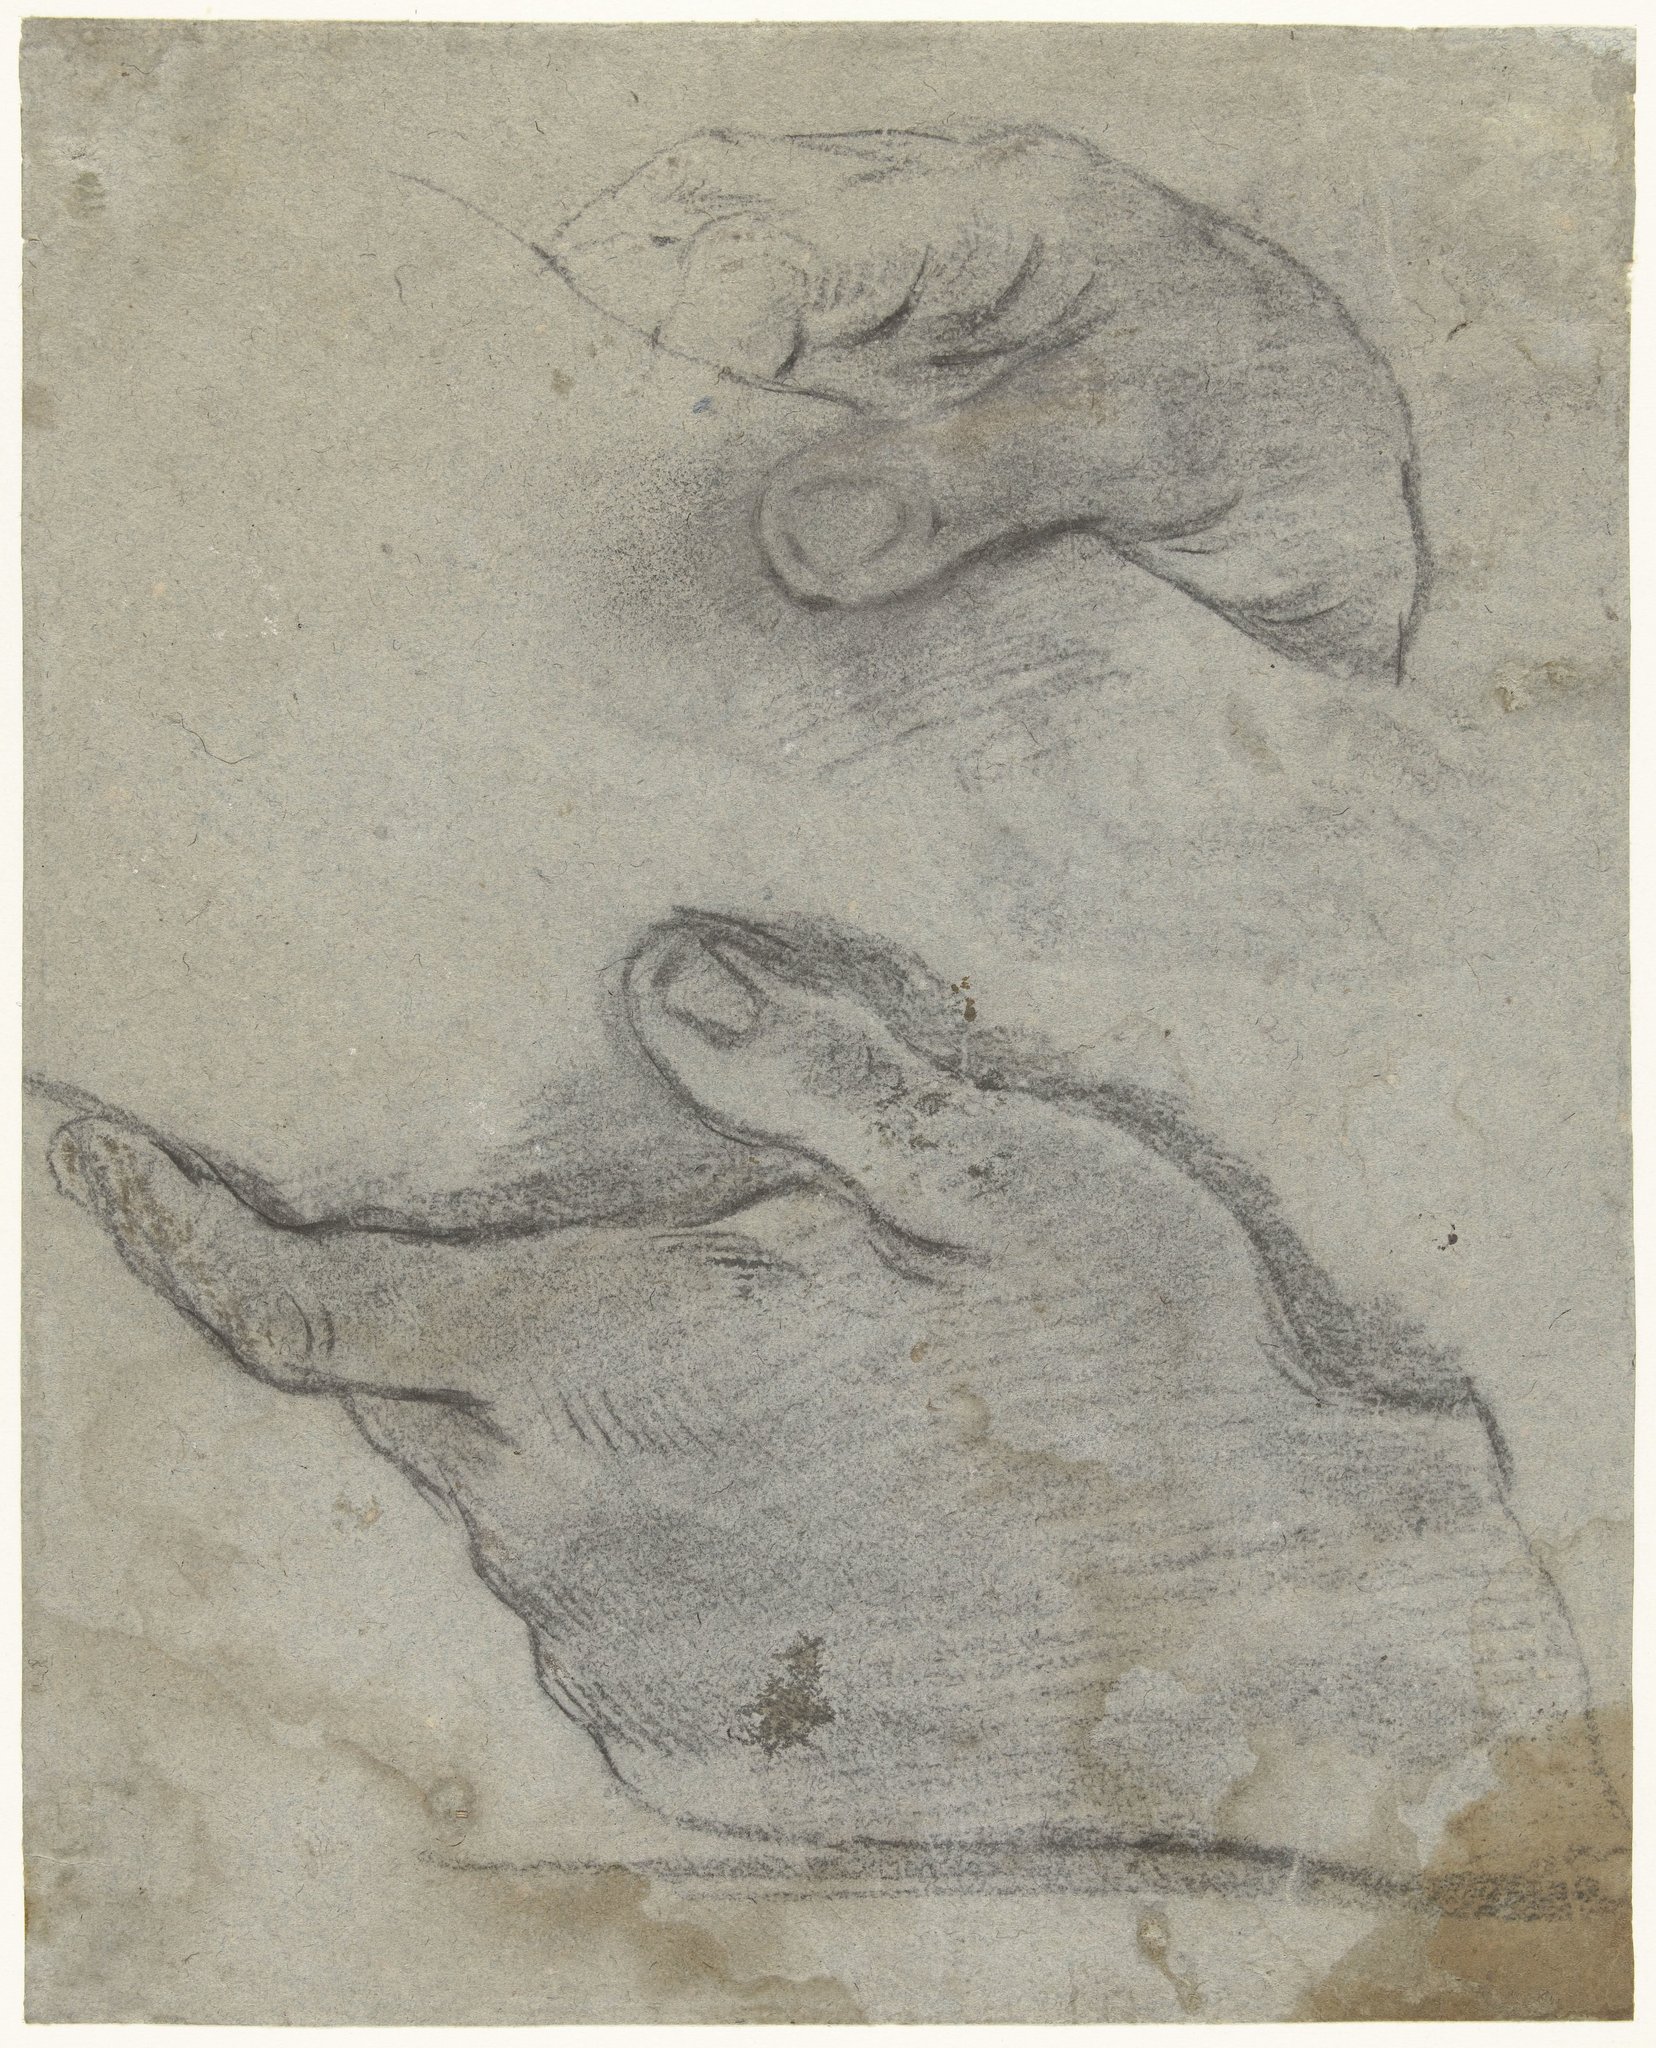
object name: drawing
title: Twee handen, die een been (?) vasthouden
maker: giacomo cavedone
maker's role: draughtsman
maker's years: 1577-1660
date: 1587-1660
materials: chalk, paper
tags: postures and gestures of hand and fingers, grasping something